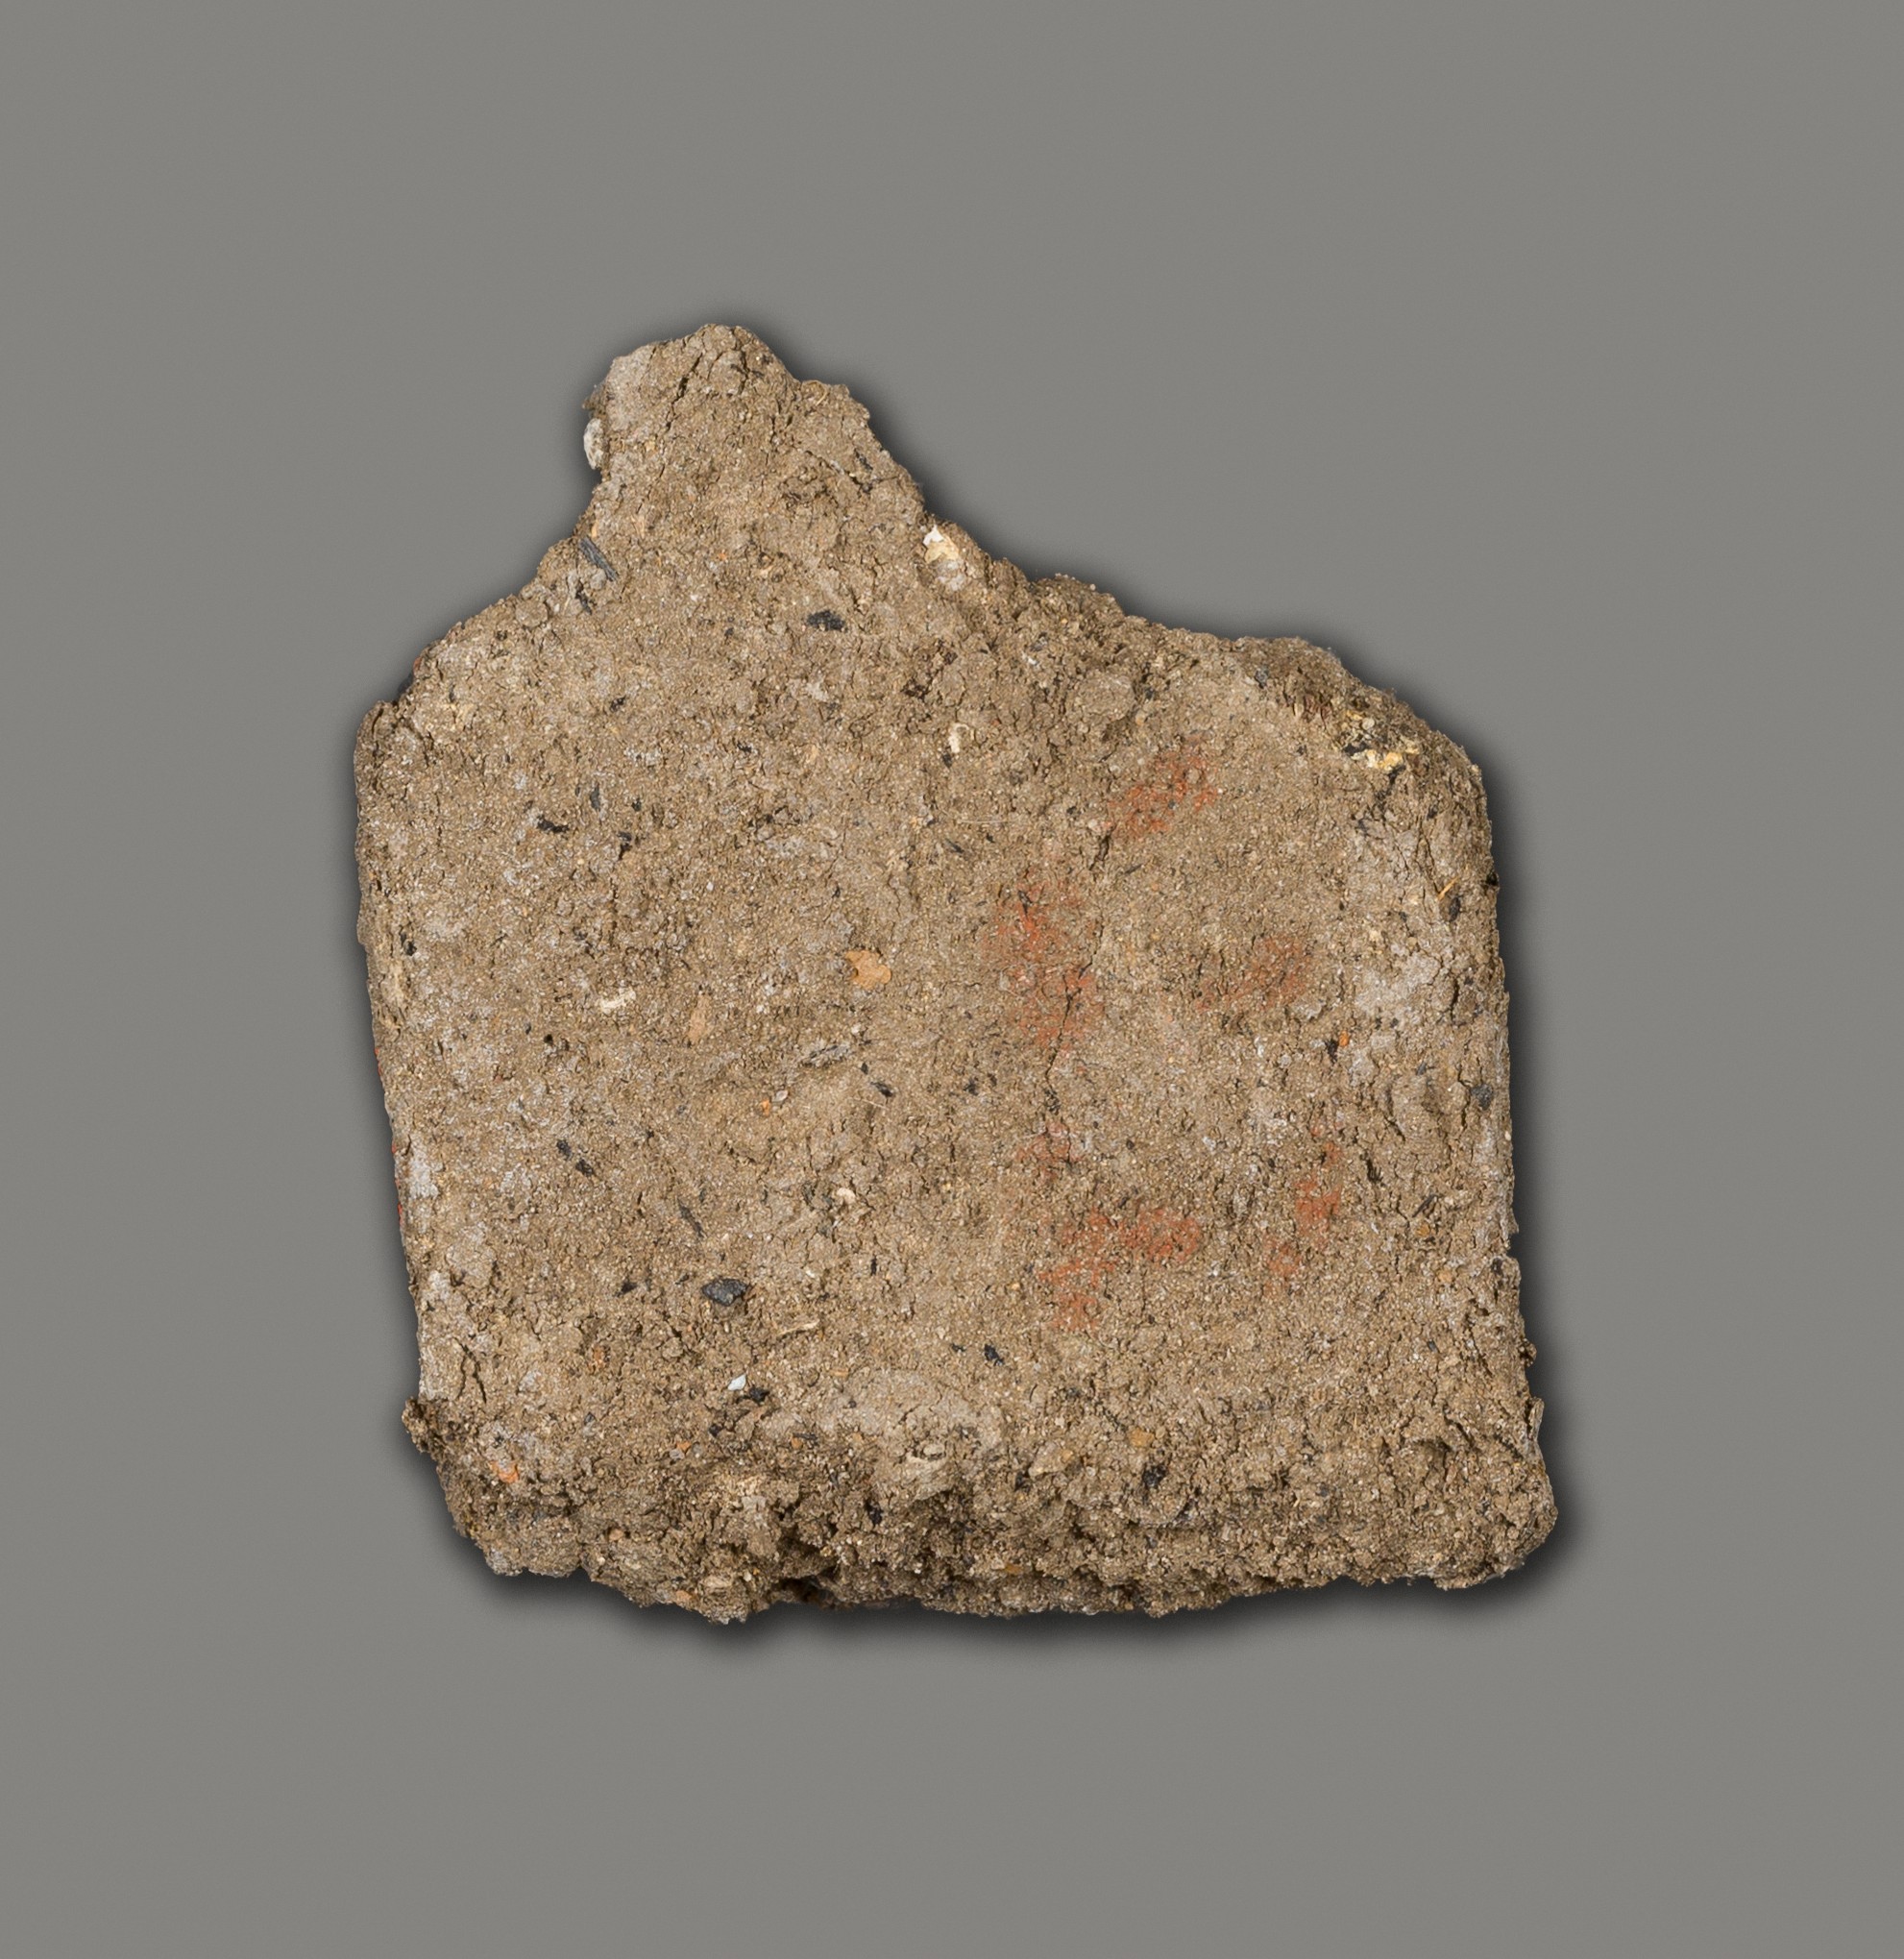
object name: figure, magical, execration, tablet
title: Magical Figure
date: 1802-1550 BCE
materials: clay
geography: egypt